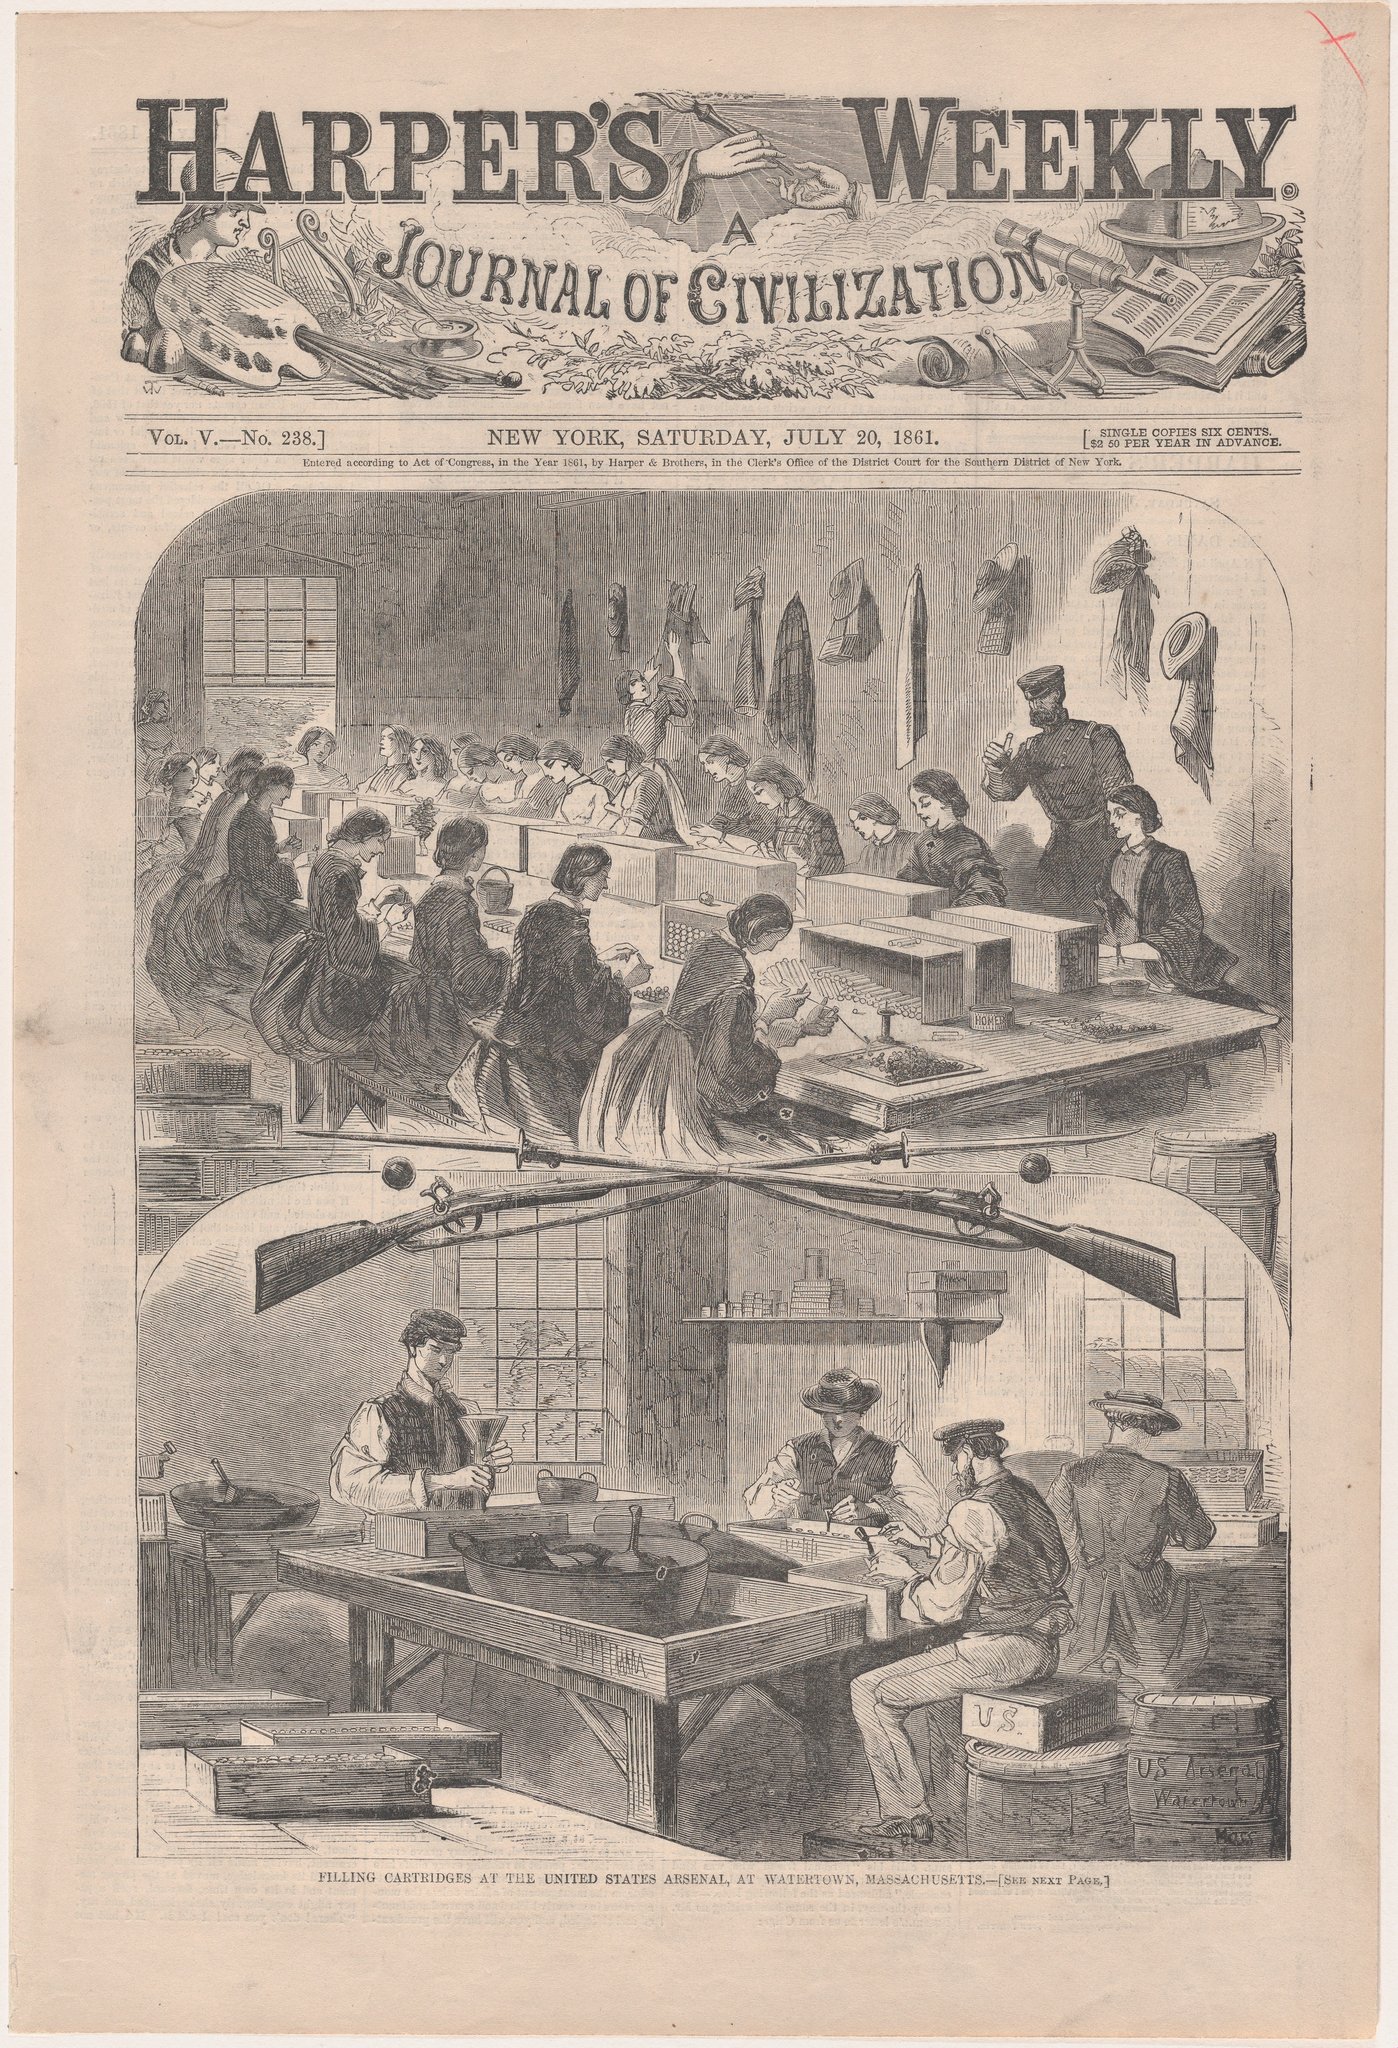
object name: print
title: Filling Cartridges at the United States Arsenal, at Watertown, Massachusetts (from "Harper's Weekly," Vol. 5, no. 238, cover)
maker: winslow homer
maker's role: artist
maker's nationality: american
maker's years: 1836-1910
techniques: engraving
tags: american civil war,men,women,working